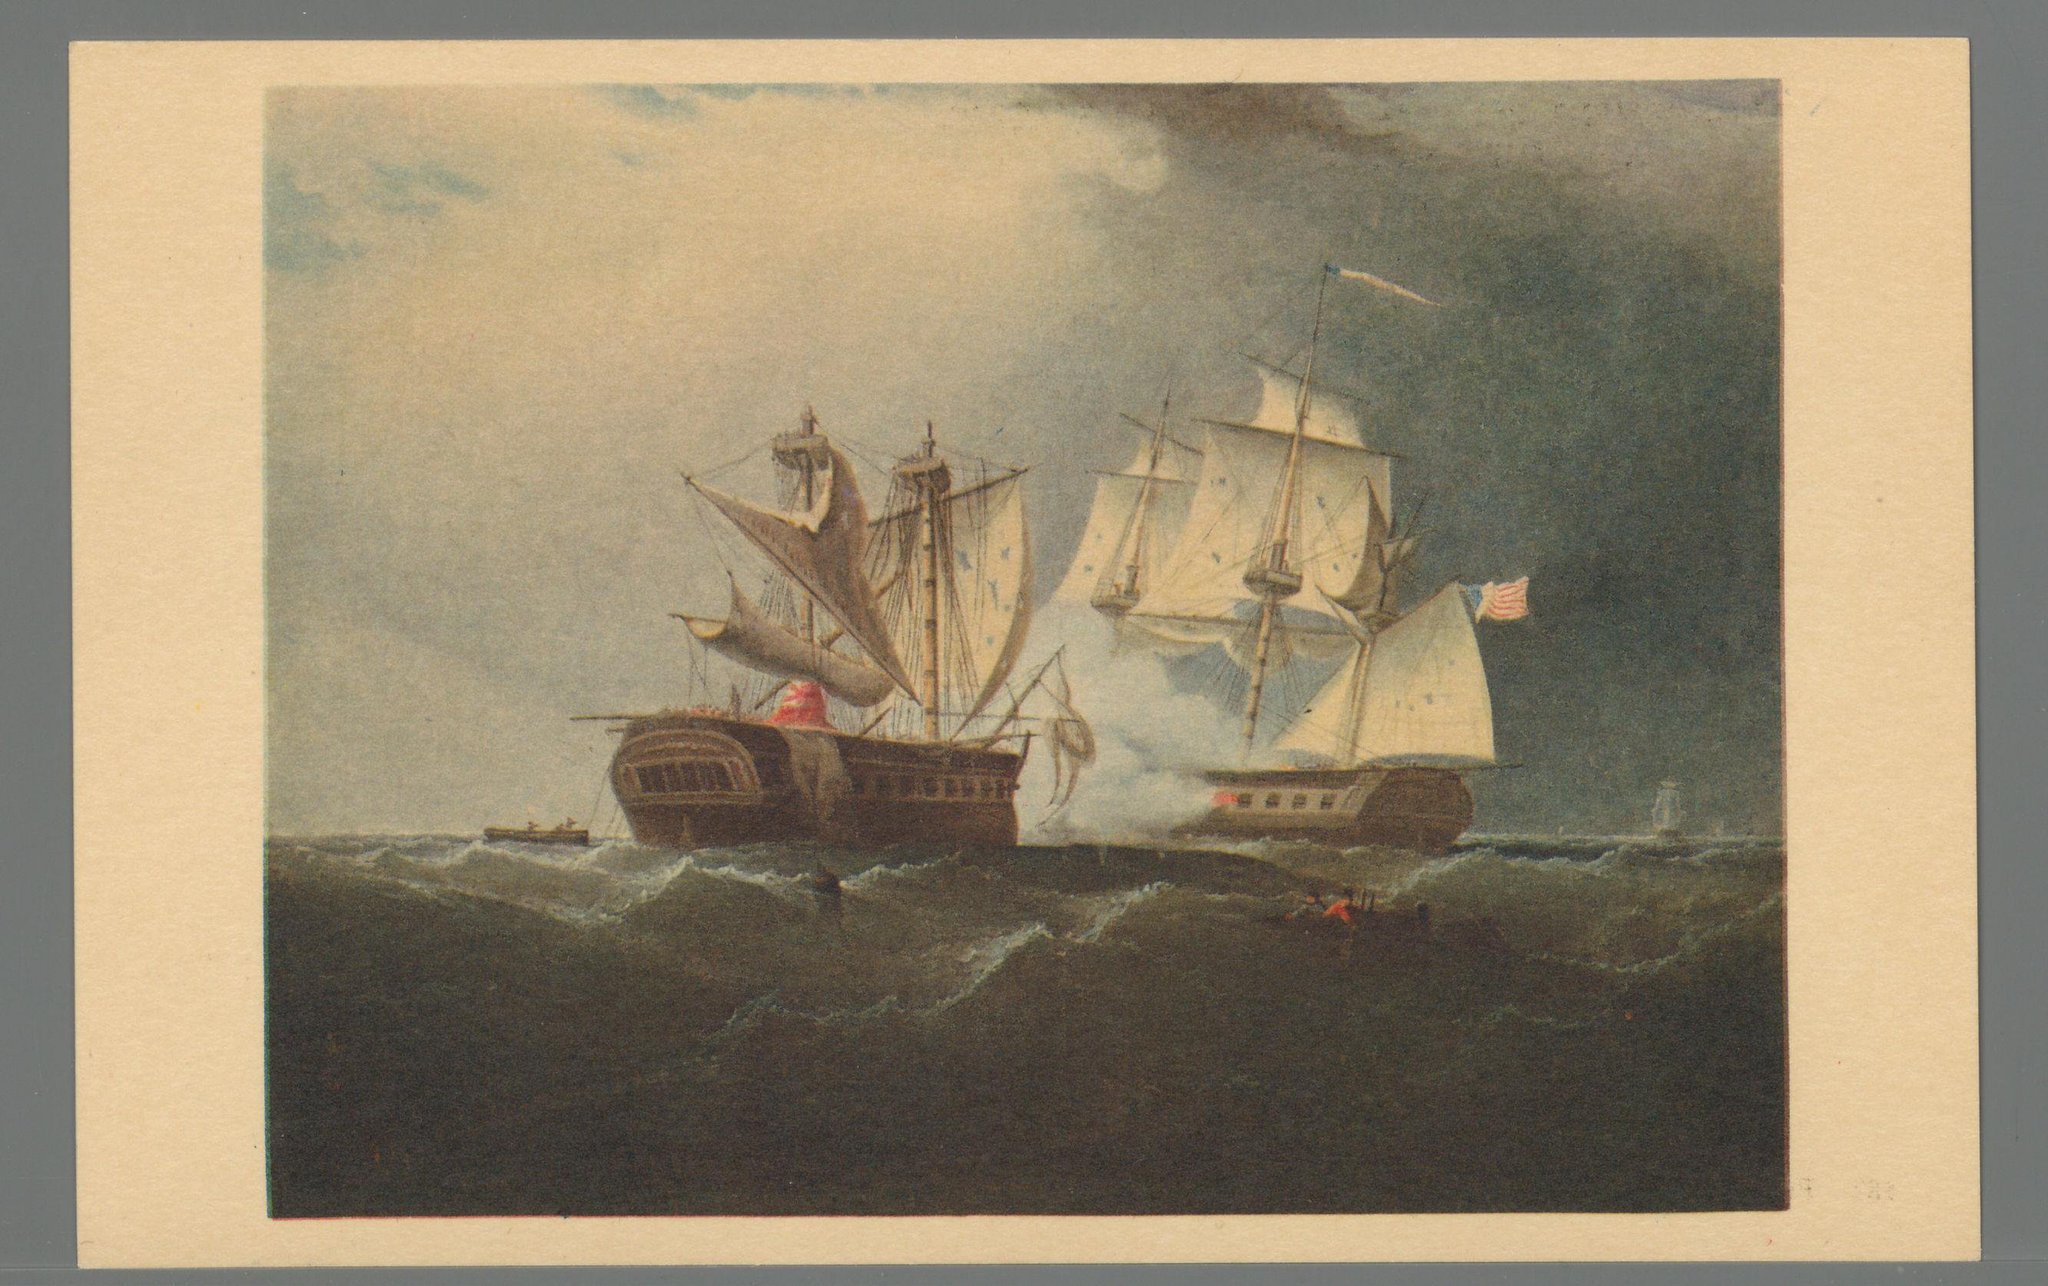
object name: ansichtkaart, prentbriefkaart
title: Engagement between the "United States" and the "Macedonian", 1812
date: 1925-1940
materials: cardboard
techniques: photograph, lithograph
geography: new york city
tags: ship's portrait, battle (+ naval force), sea (seascape)